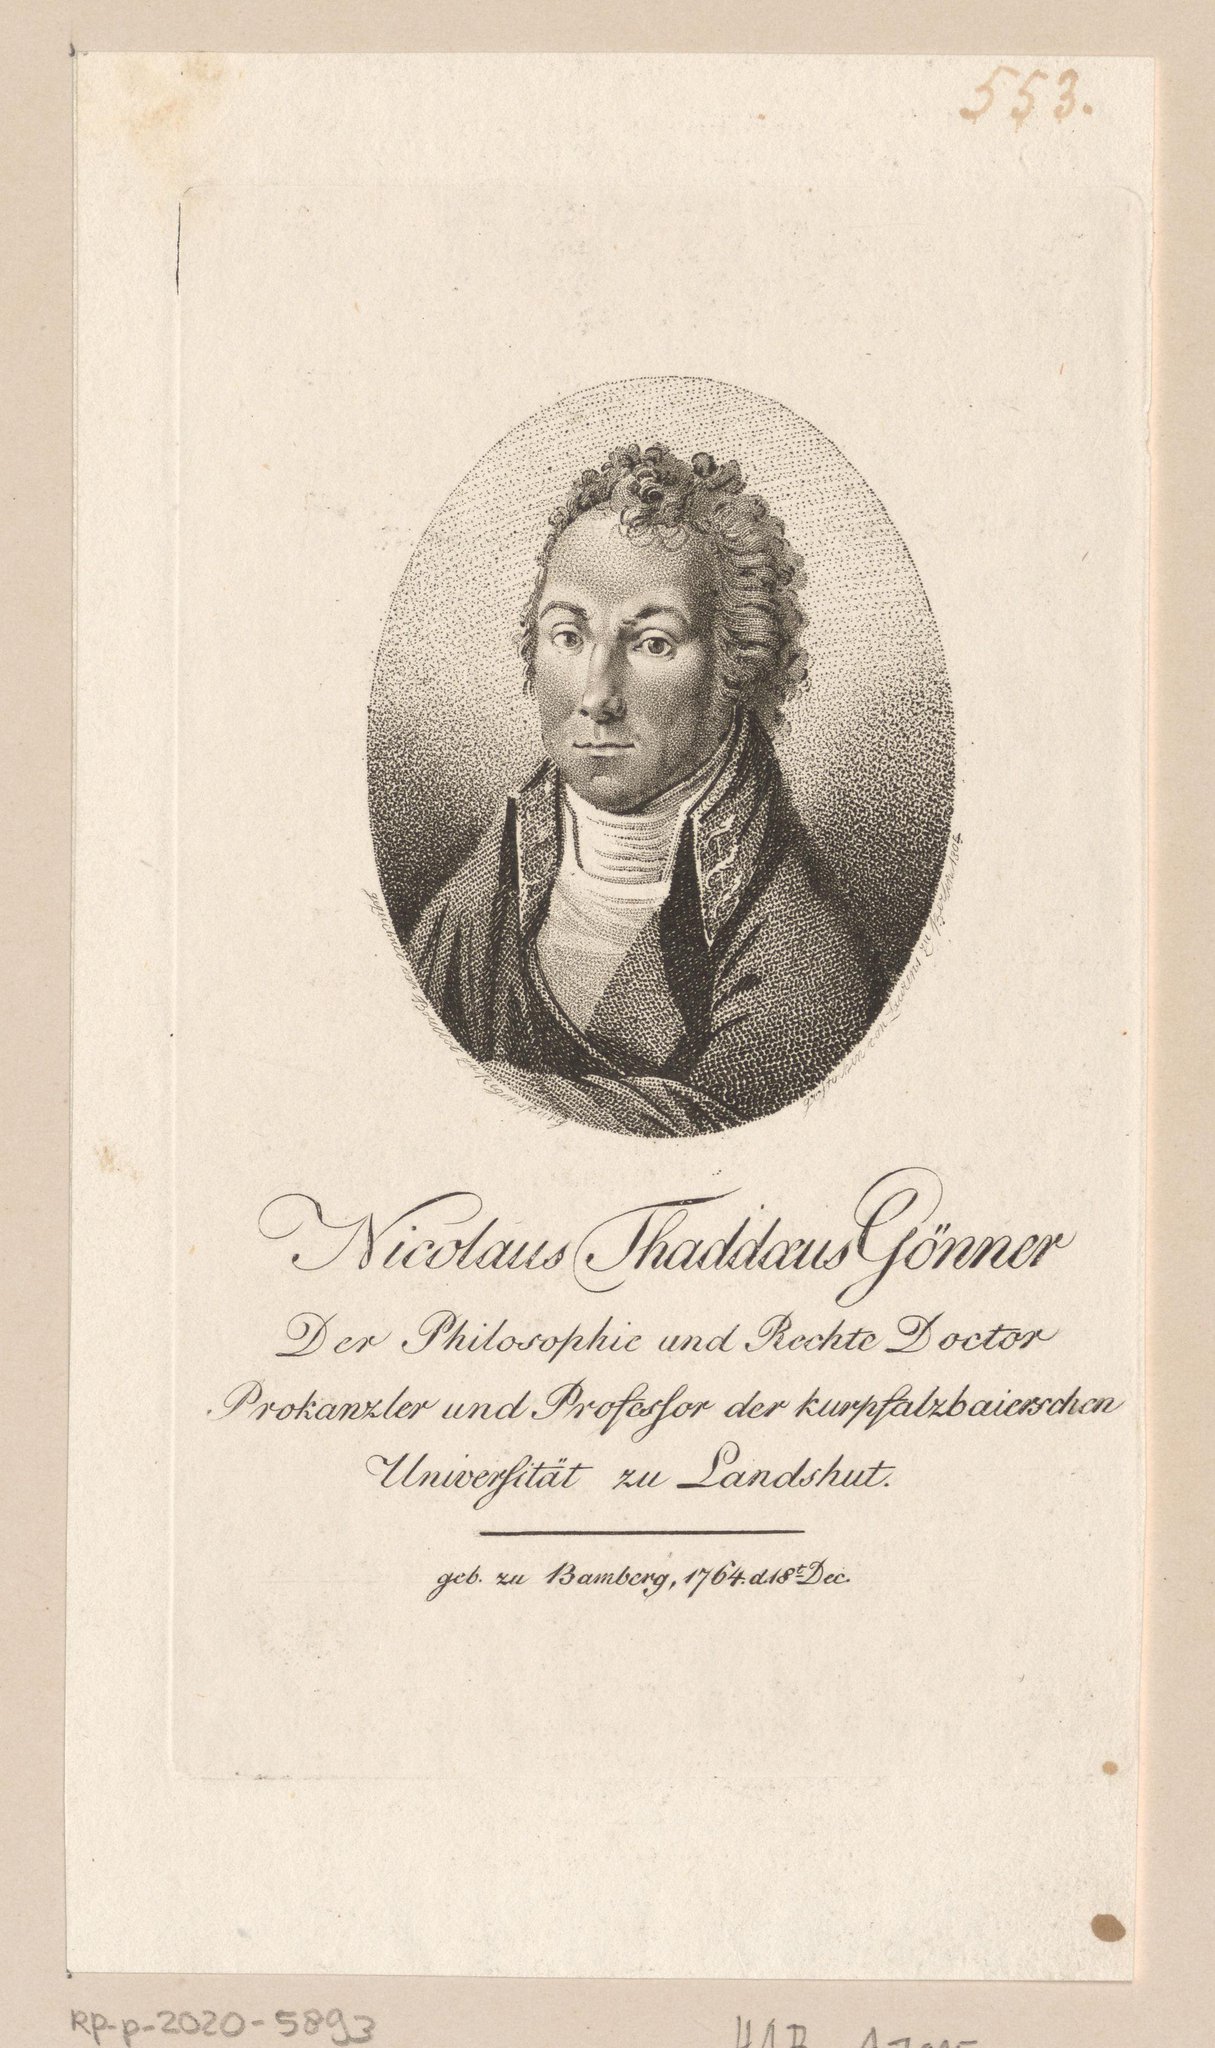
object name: print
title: Portret van Nikolaus Thaddäus von Gönner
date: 1805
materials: paper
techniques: stippling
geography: berlin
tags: historical persons, lawyer, attorney at law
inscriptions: date